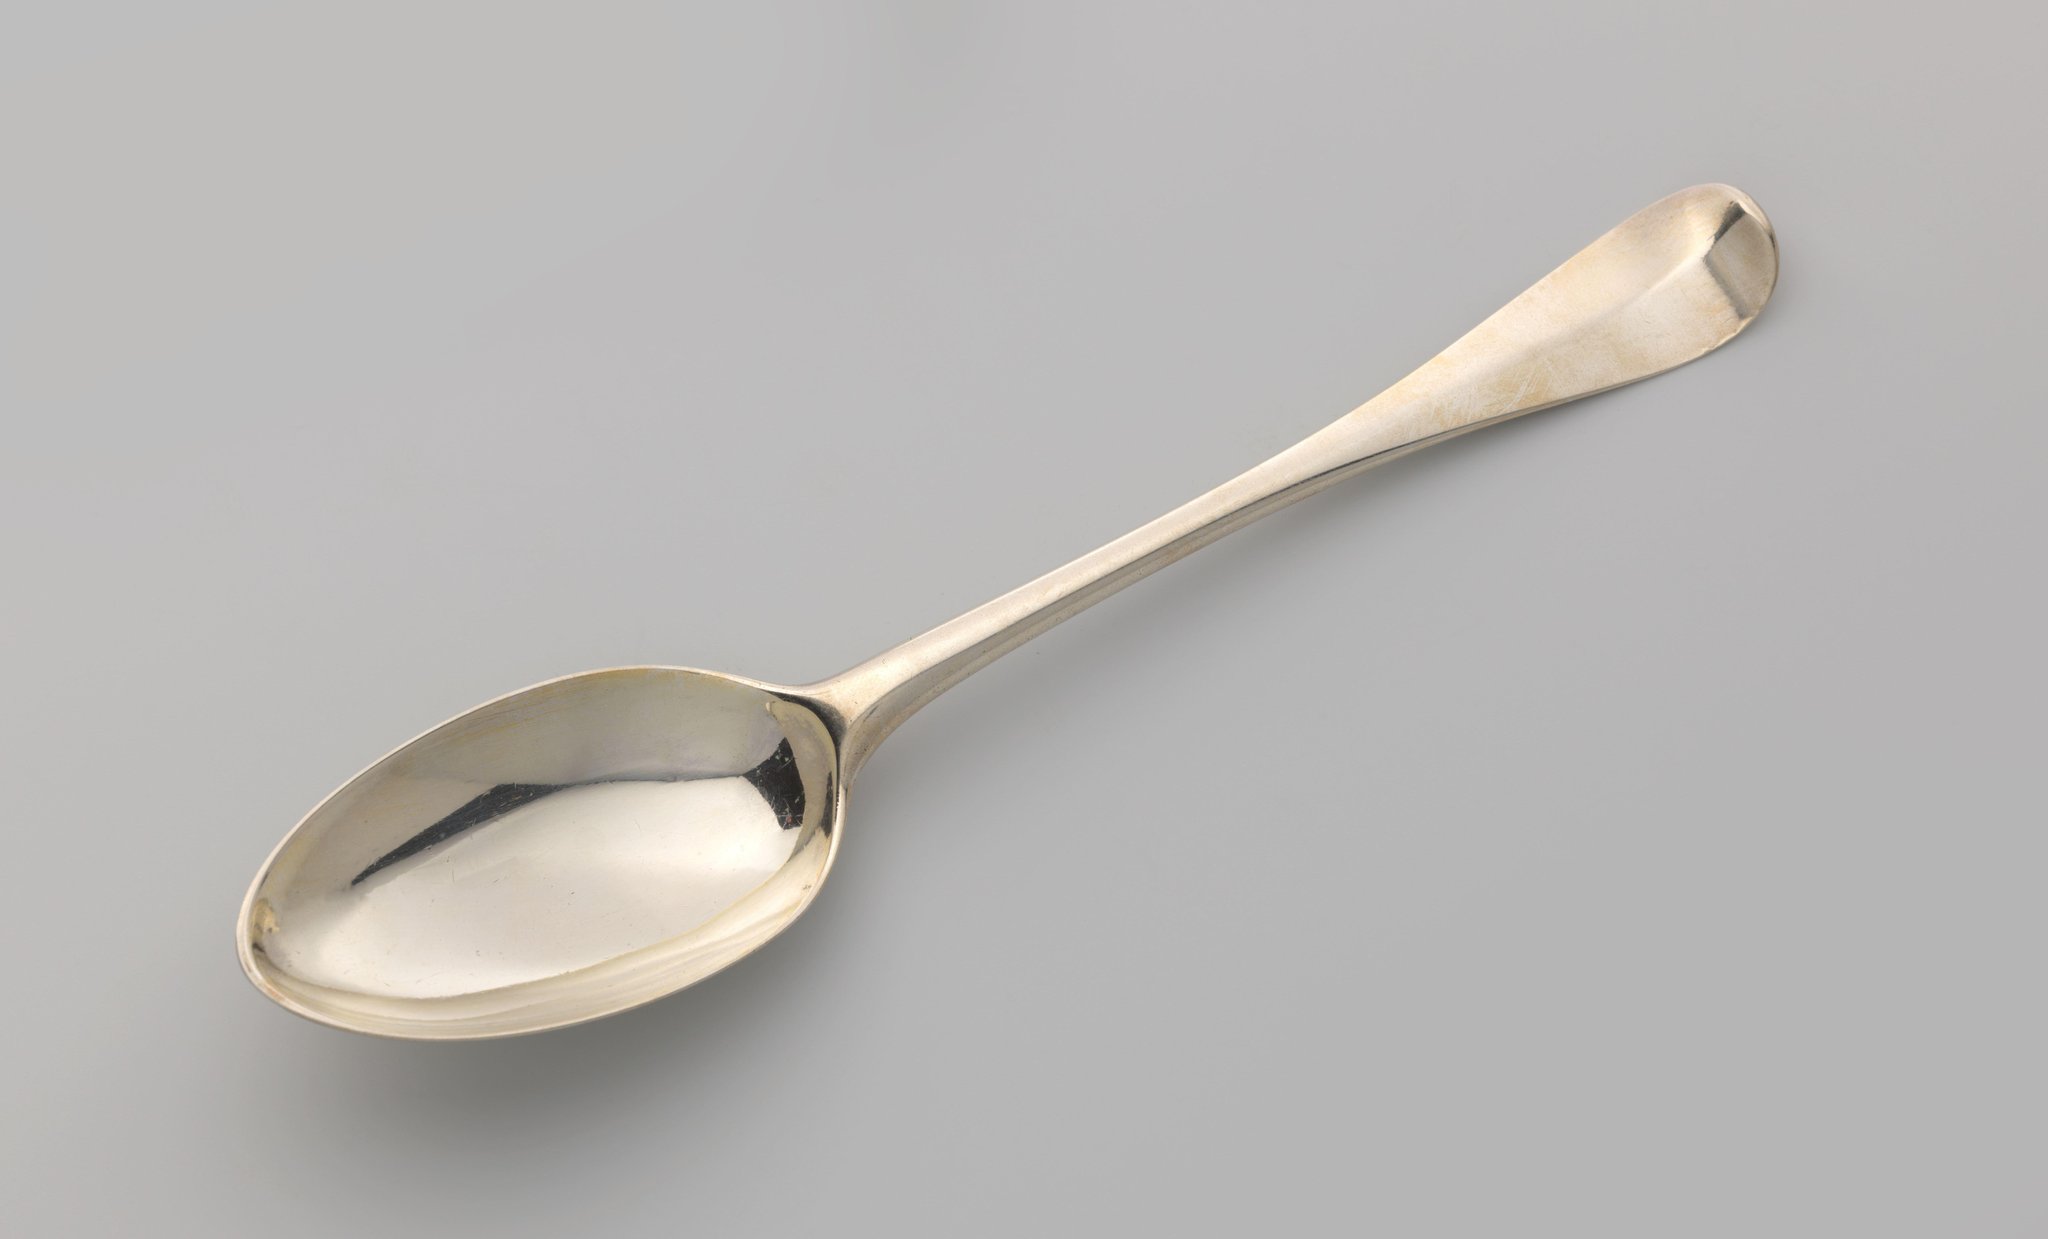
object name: flatware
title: Lepel met eivormige bak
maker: jacob helweg (i)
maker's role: silversmith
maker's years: 1725-1778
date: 1764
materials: silver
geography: amsterdam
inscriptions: duty mark, alloy mark, date letter: ‘E’, maker's mark, town mark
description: De eivormige bak van de lepel is door middel van enkel lof verbonden met de platte, gebogen steel, die zich verbreedt naar het afgeronde uiteinde en die aan de bovenzijde over het midden een ribbel vertoont.